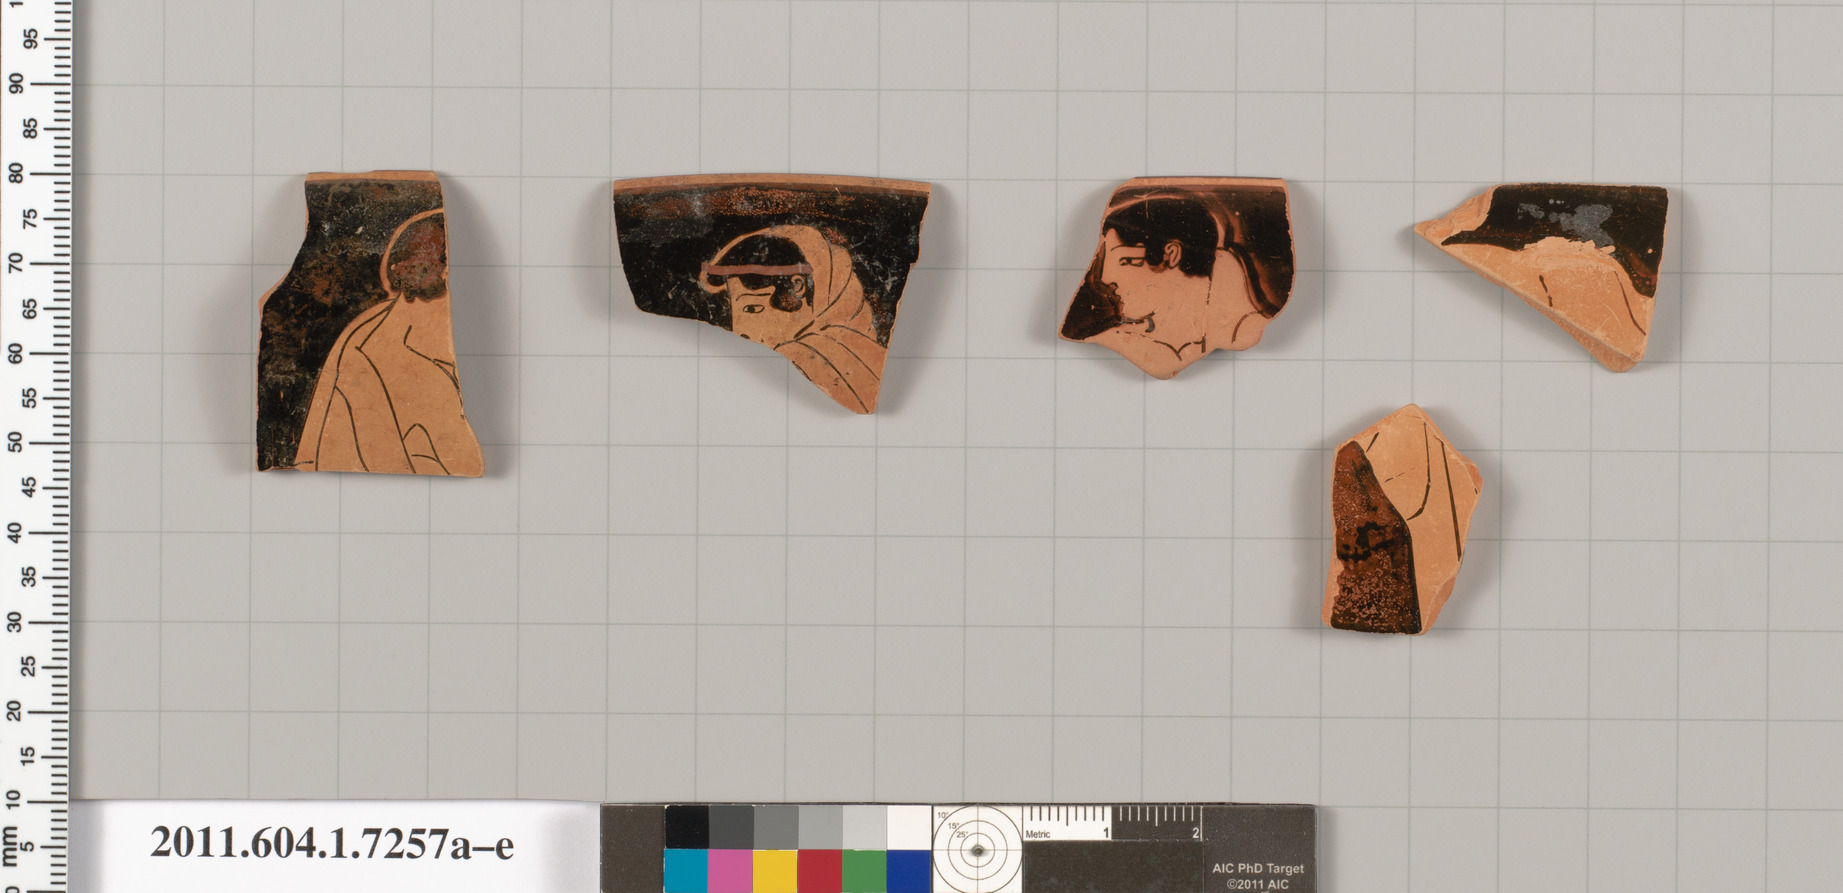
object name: kylix fragment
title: Terracotta fragments of a kylix (drinking cup)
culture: greek, attic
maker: makron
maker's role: artist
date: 500-480 BCE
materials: terracotta